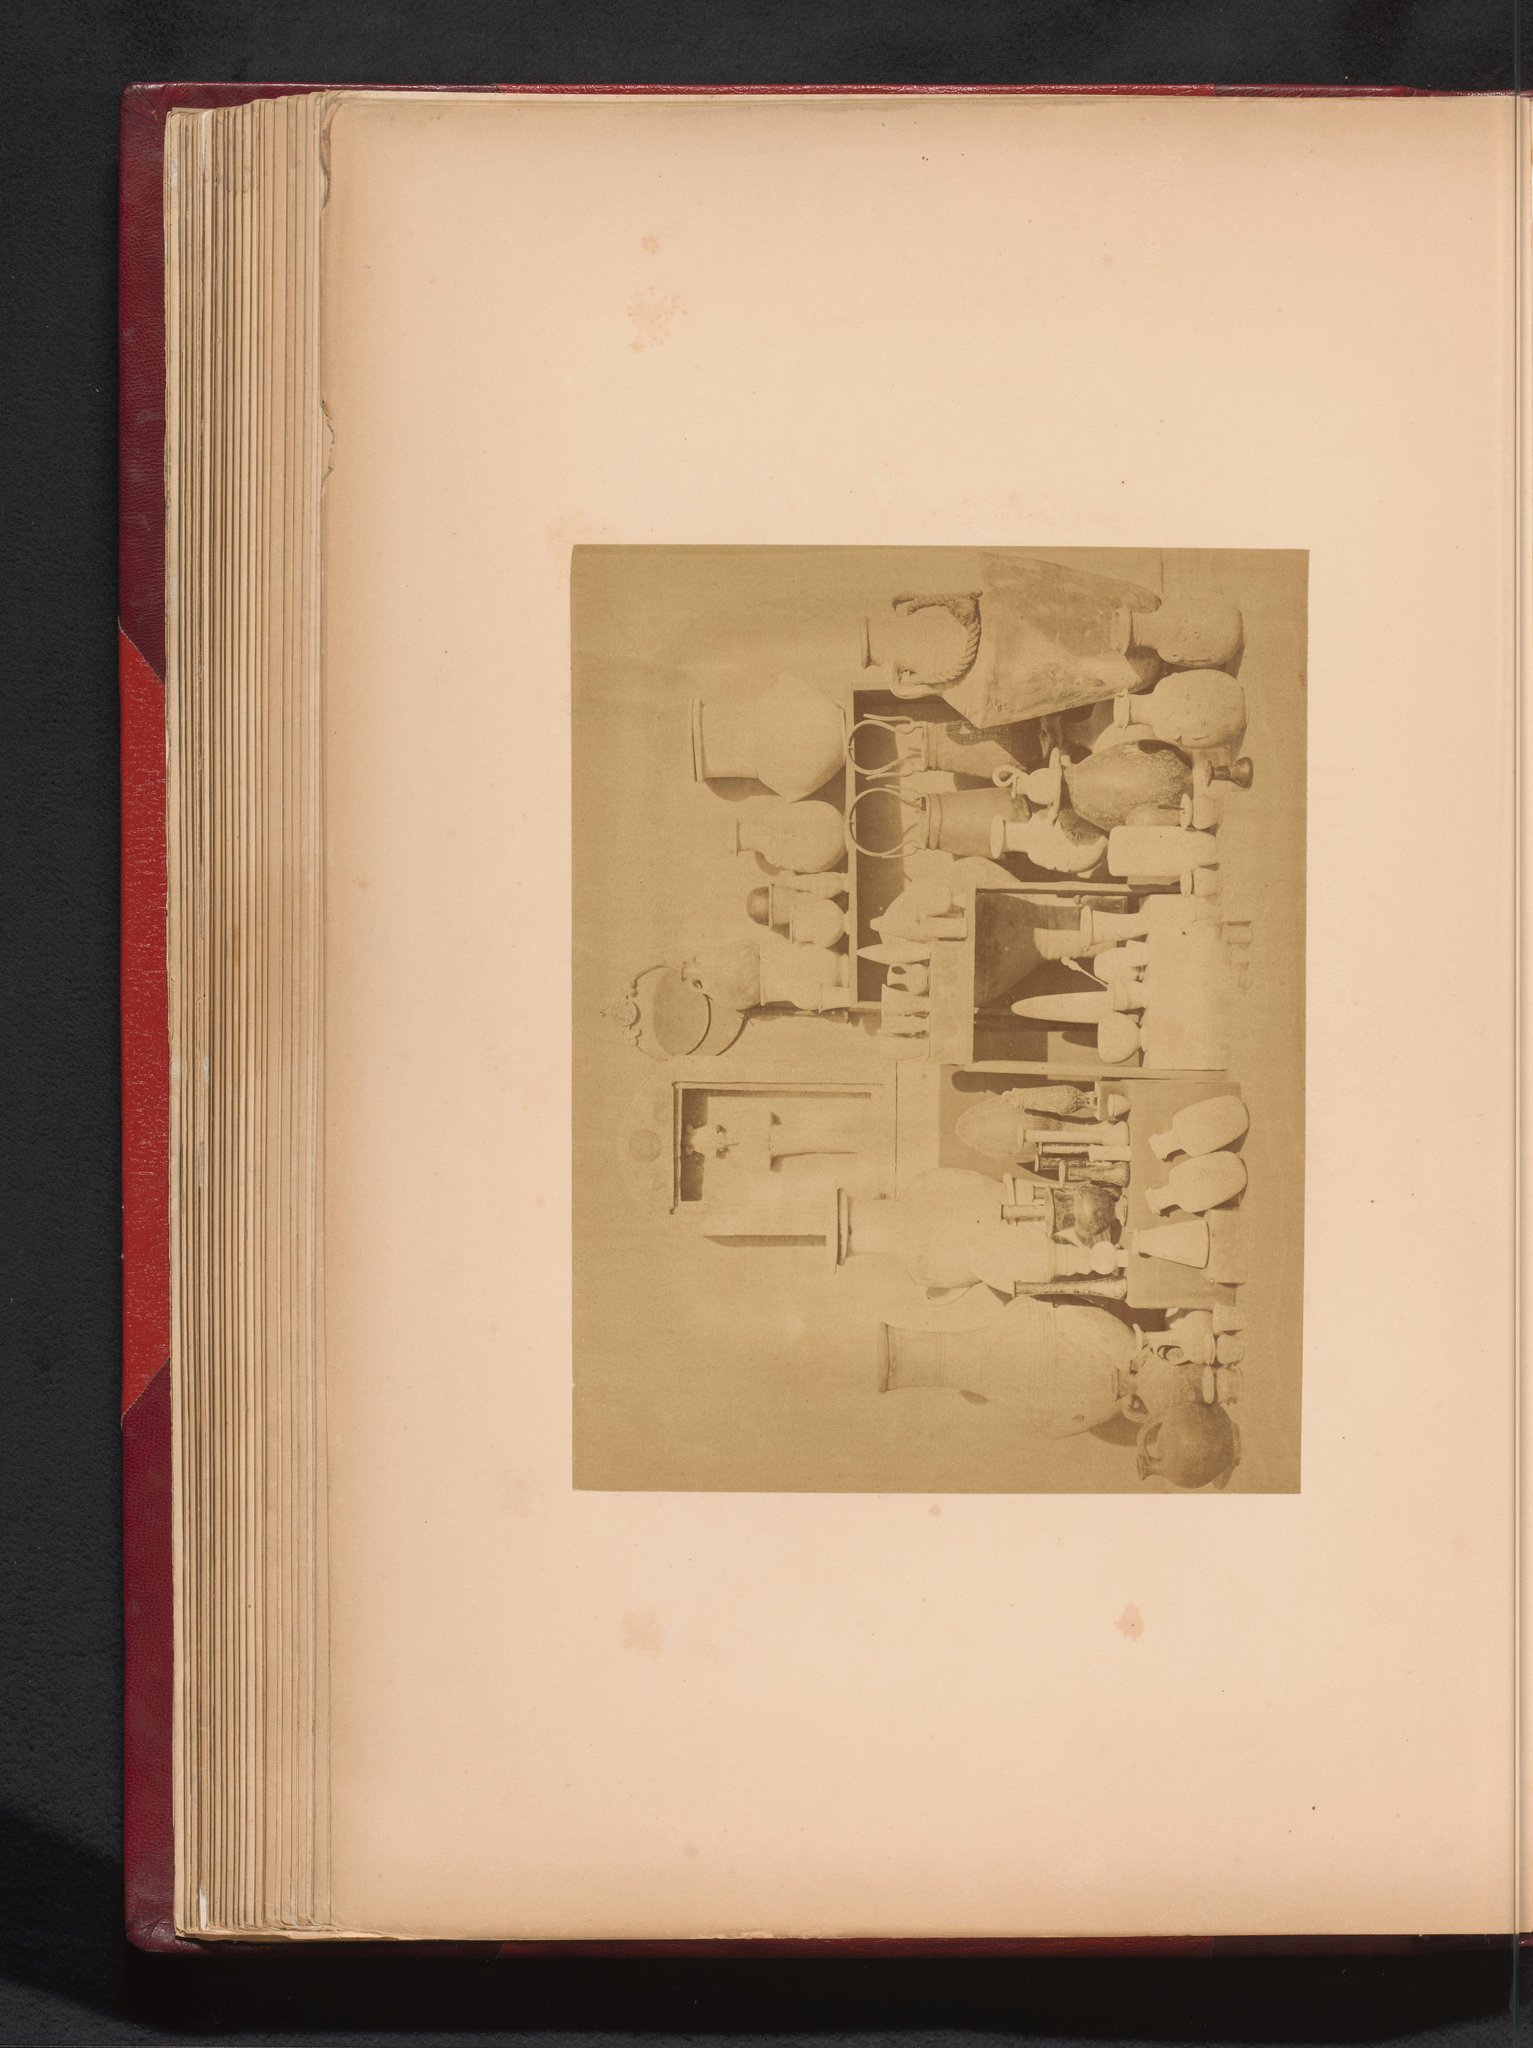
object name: page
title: Vazen in het Boulaq Museum in Caïro, Egypte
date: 1866-1871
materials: photographic support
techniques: albumen print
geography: cairo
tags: permanent exhibition, museum, container of ceramics: jar, jug, pot, vase